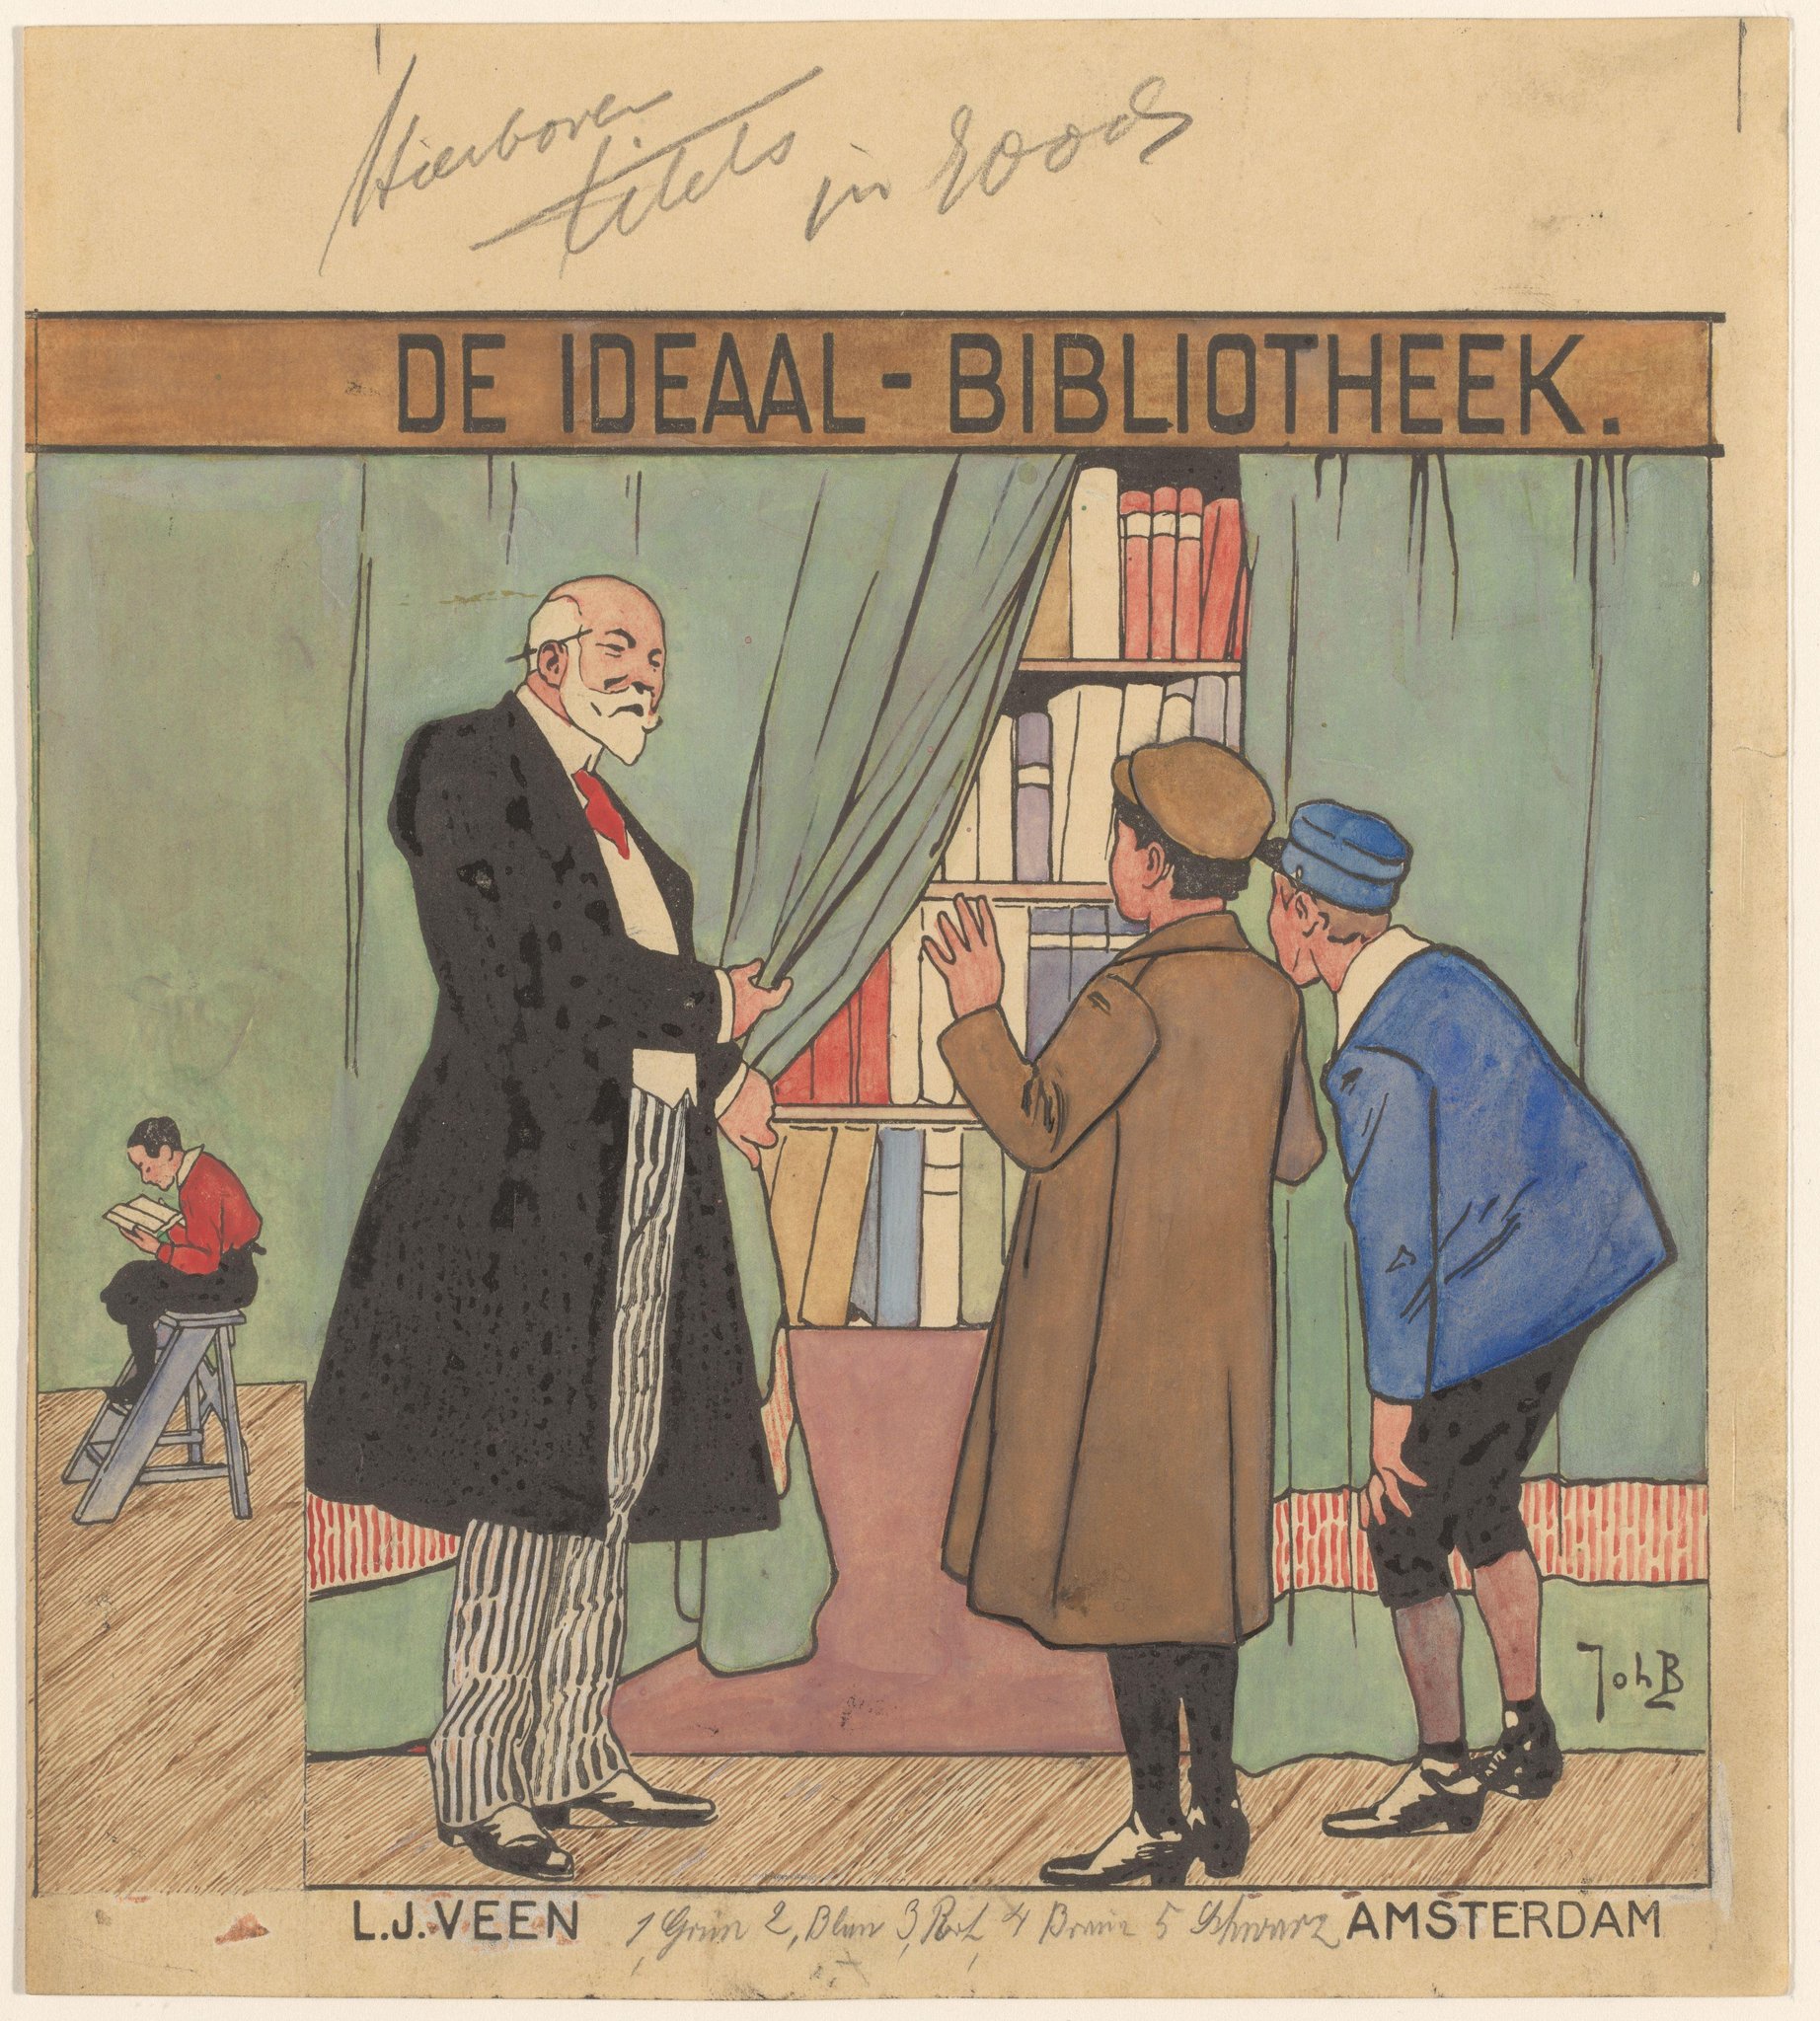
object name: study for binding design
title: Bandontwerp voor de serie: De Ideaal-Bibliotheek van uitgeversmaatschappij L.J. Veen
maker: johan braakensiek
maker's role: draughtsman, print maker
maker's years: 1858-1940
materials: ink, paper, pencil, watercolor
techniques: brush, pen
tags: bookshelves, reading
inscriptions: annotation: ‘hierboven/ titels/ in rood’, :, collector's mark: Lugt 2228a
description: Een man in een lange jas schuift een gordijn opzij en toont twee jongens de boekenkast die daar achter schuilgaat. Op de boekrug een jongen die zit te lezen op een trap.